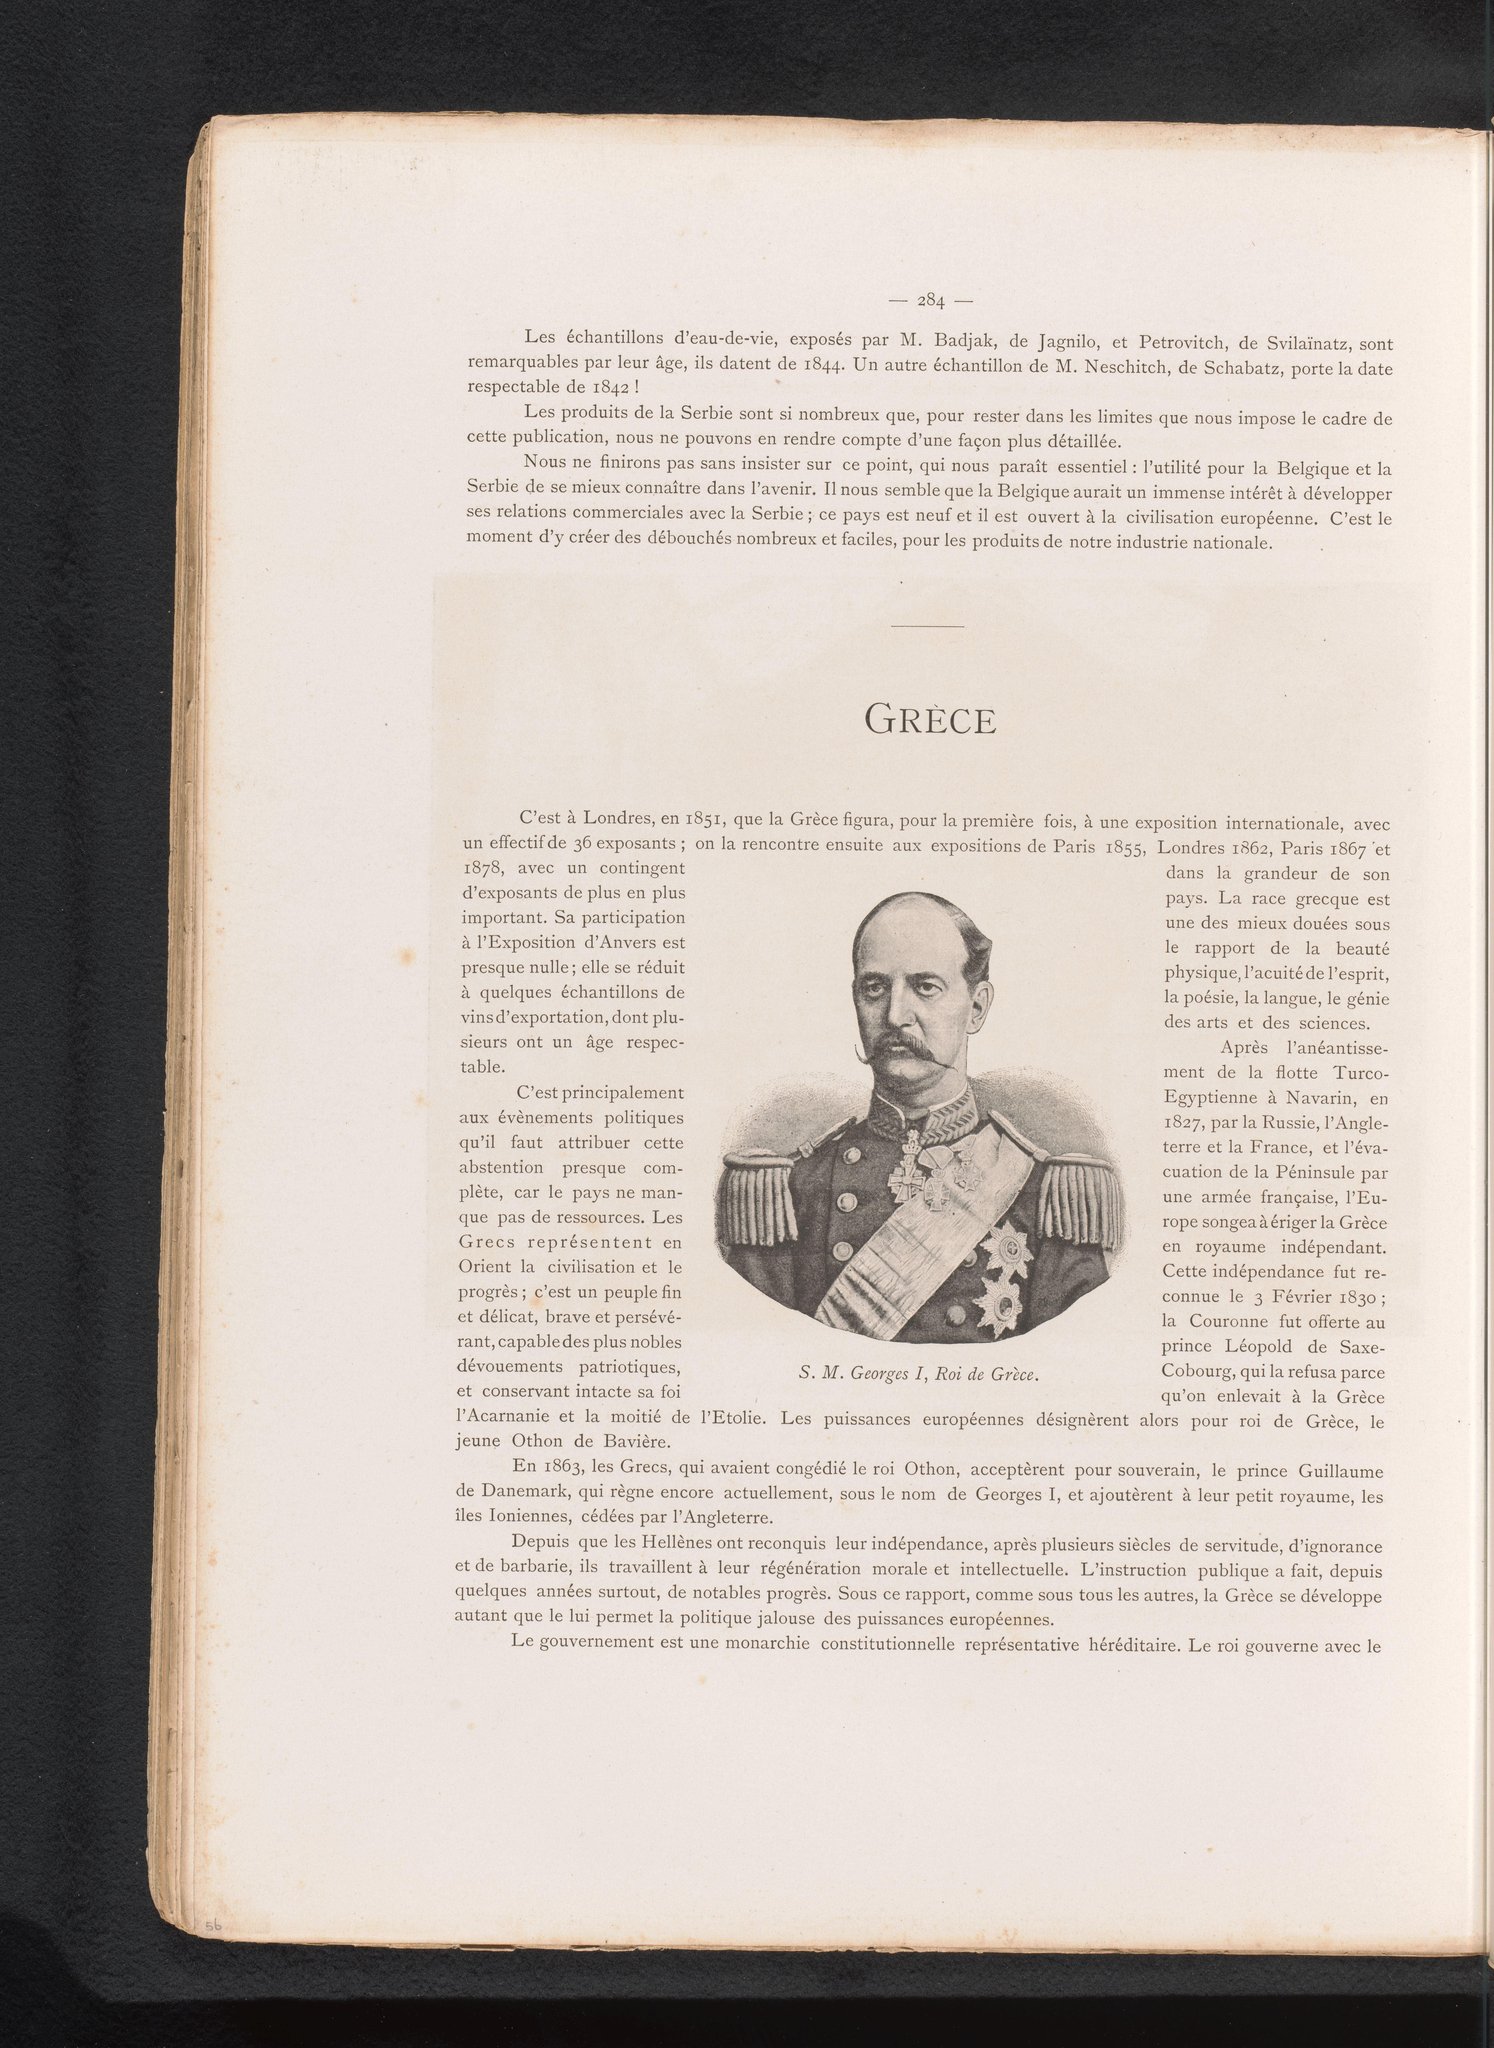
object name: page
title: S. M. Georges I, Roi de Grèce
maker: Anonymous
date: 1880-1885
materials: paper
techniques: autotype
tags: historical persons, king